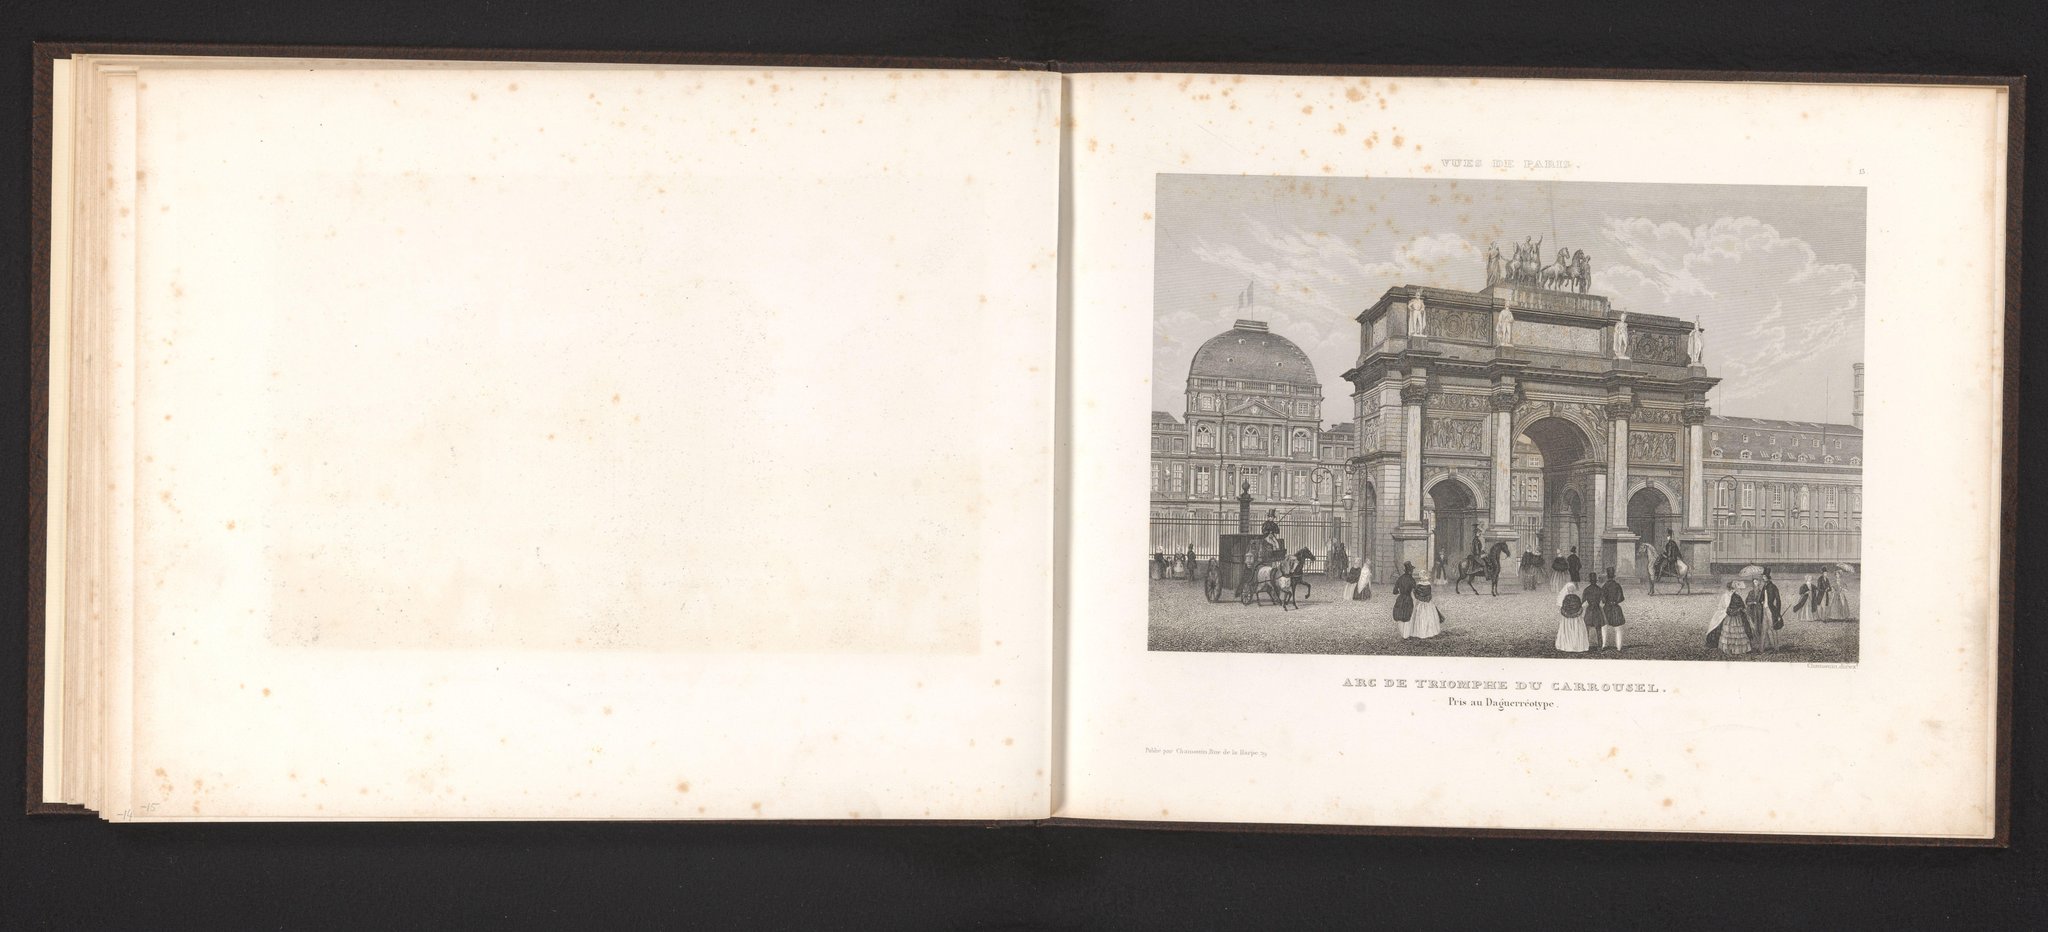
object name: page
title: Arc de Triomphe du Carrousel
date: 1845-1850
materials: paper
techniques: engraving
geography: paris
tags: triumphal arch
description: Prent op zestiende ongenummerde pagina na titelpagina. Prent gemaakt naar daguerreotypie.